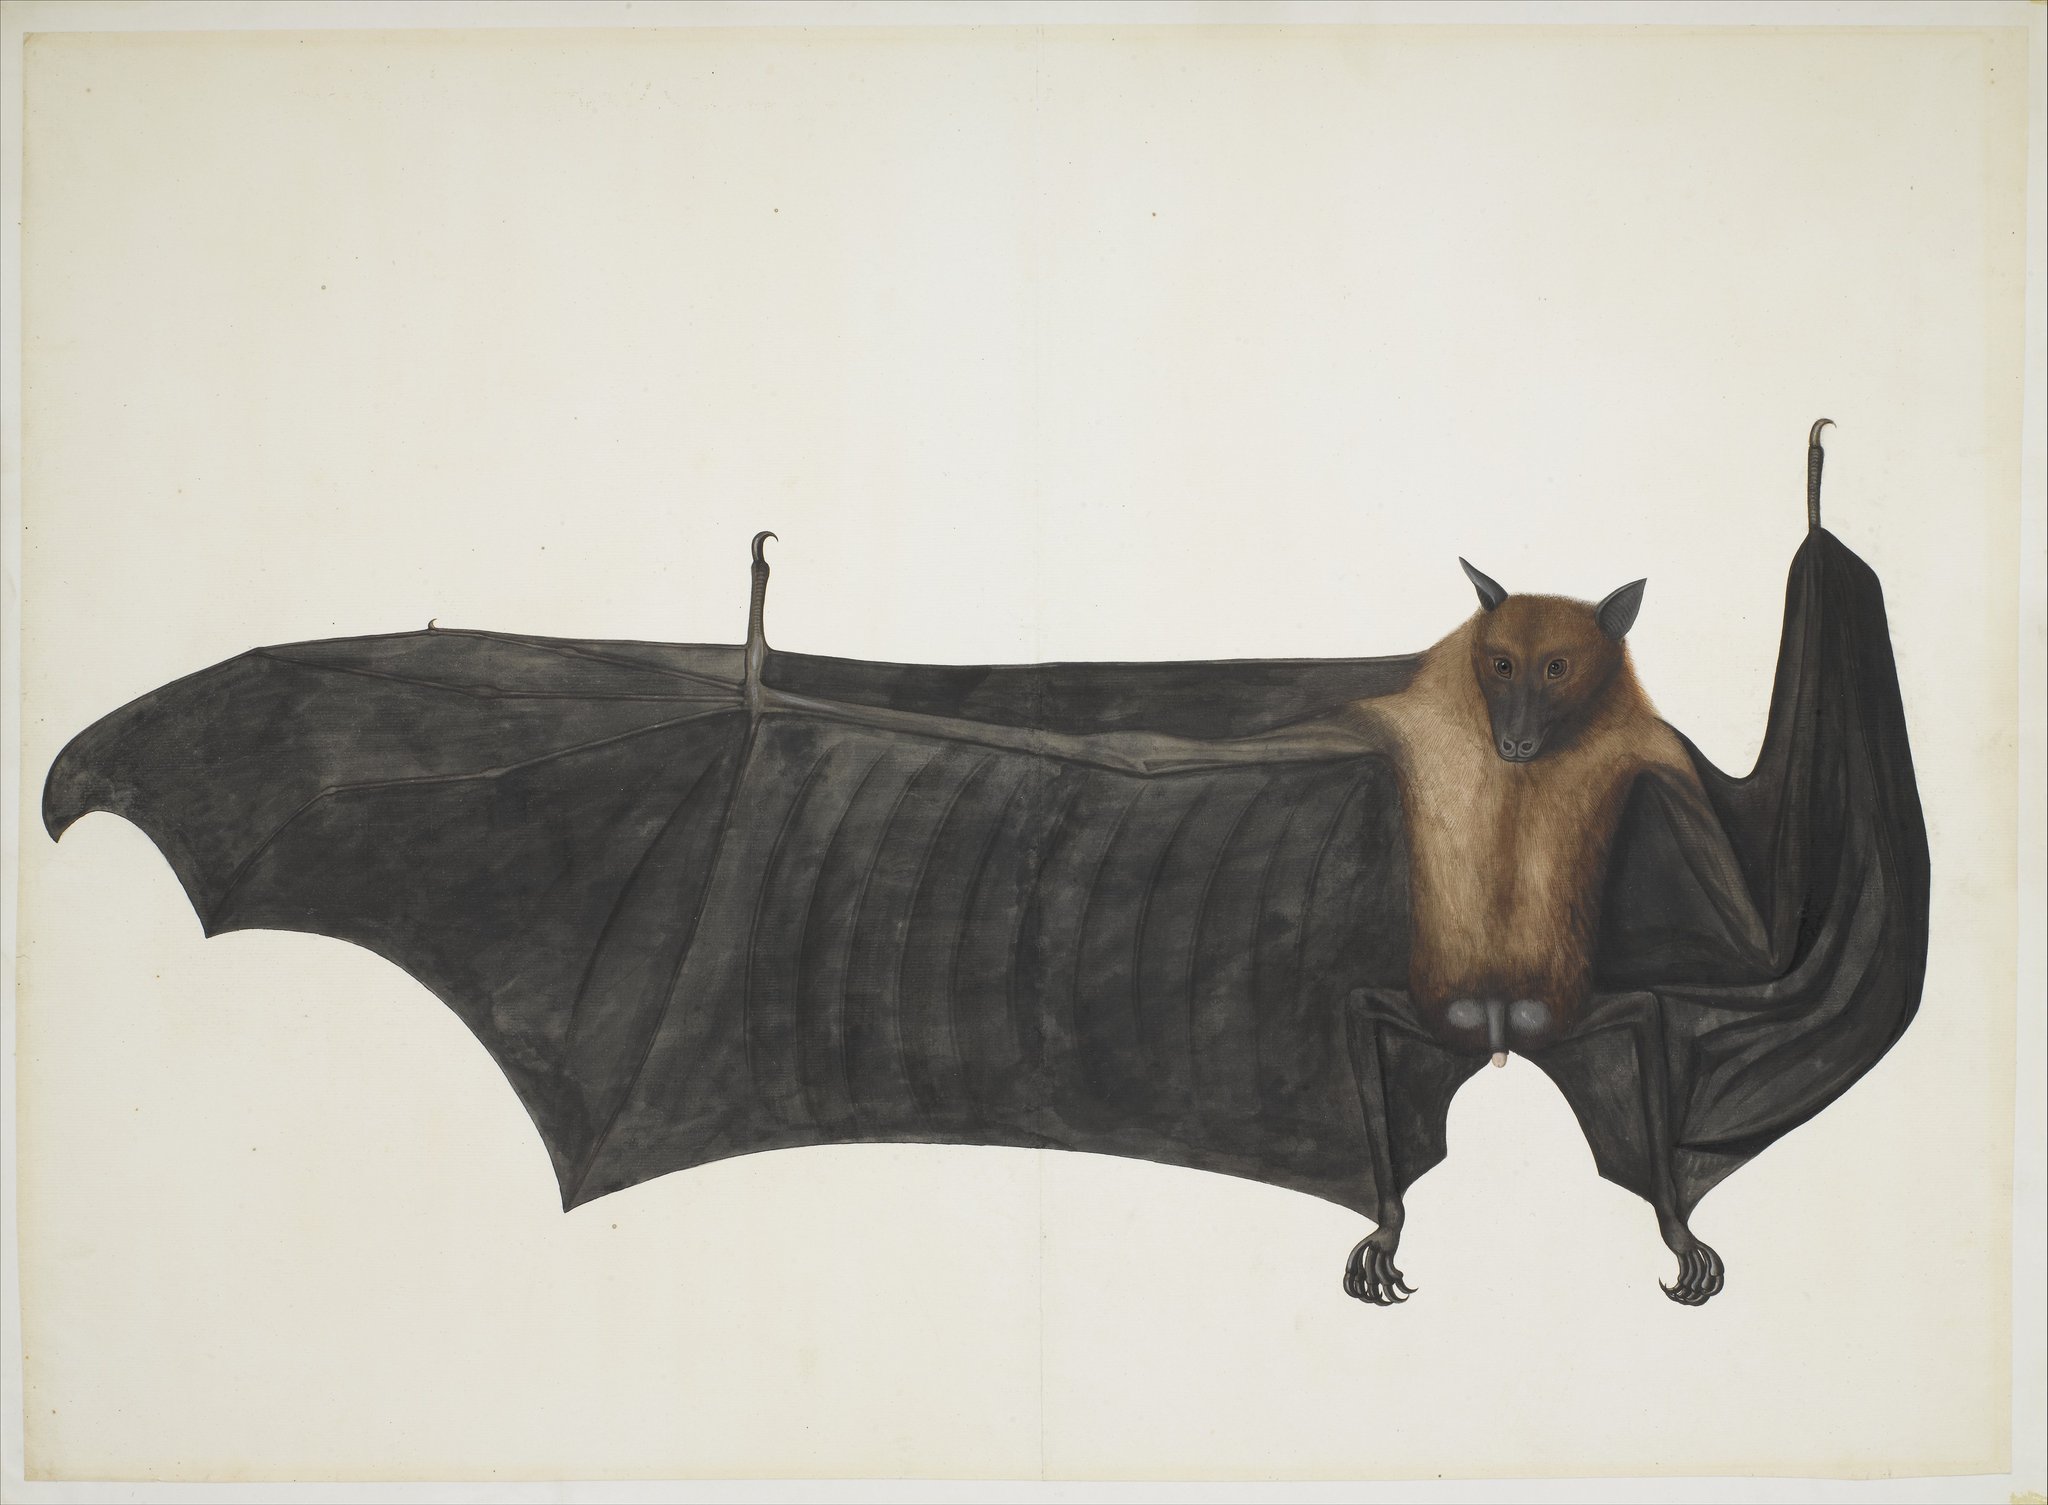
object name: painting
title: Great Indian Fruit Bat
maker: bhawani das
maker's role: artist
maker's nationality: indian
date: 1777-1782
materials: ink, paper, pencil, watercolor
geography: india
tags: bats